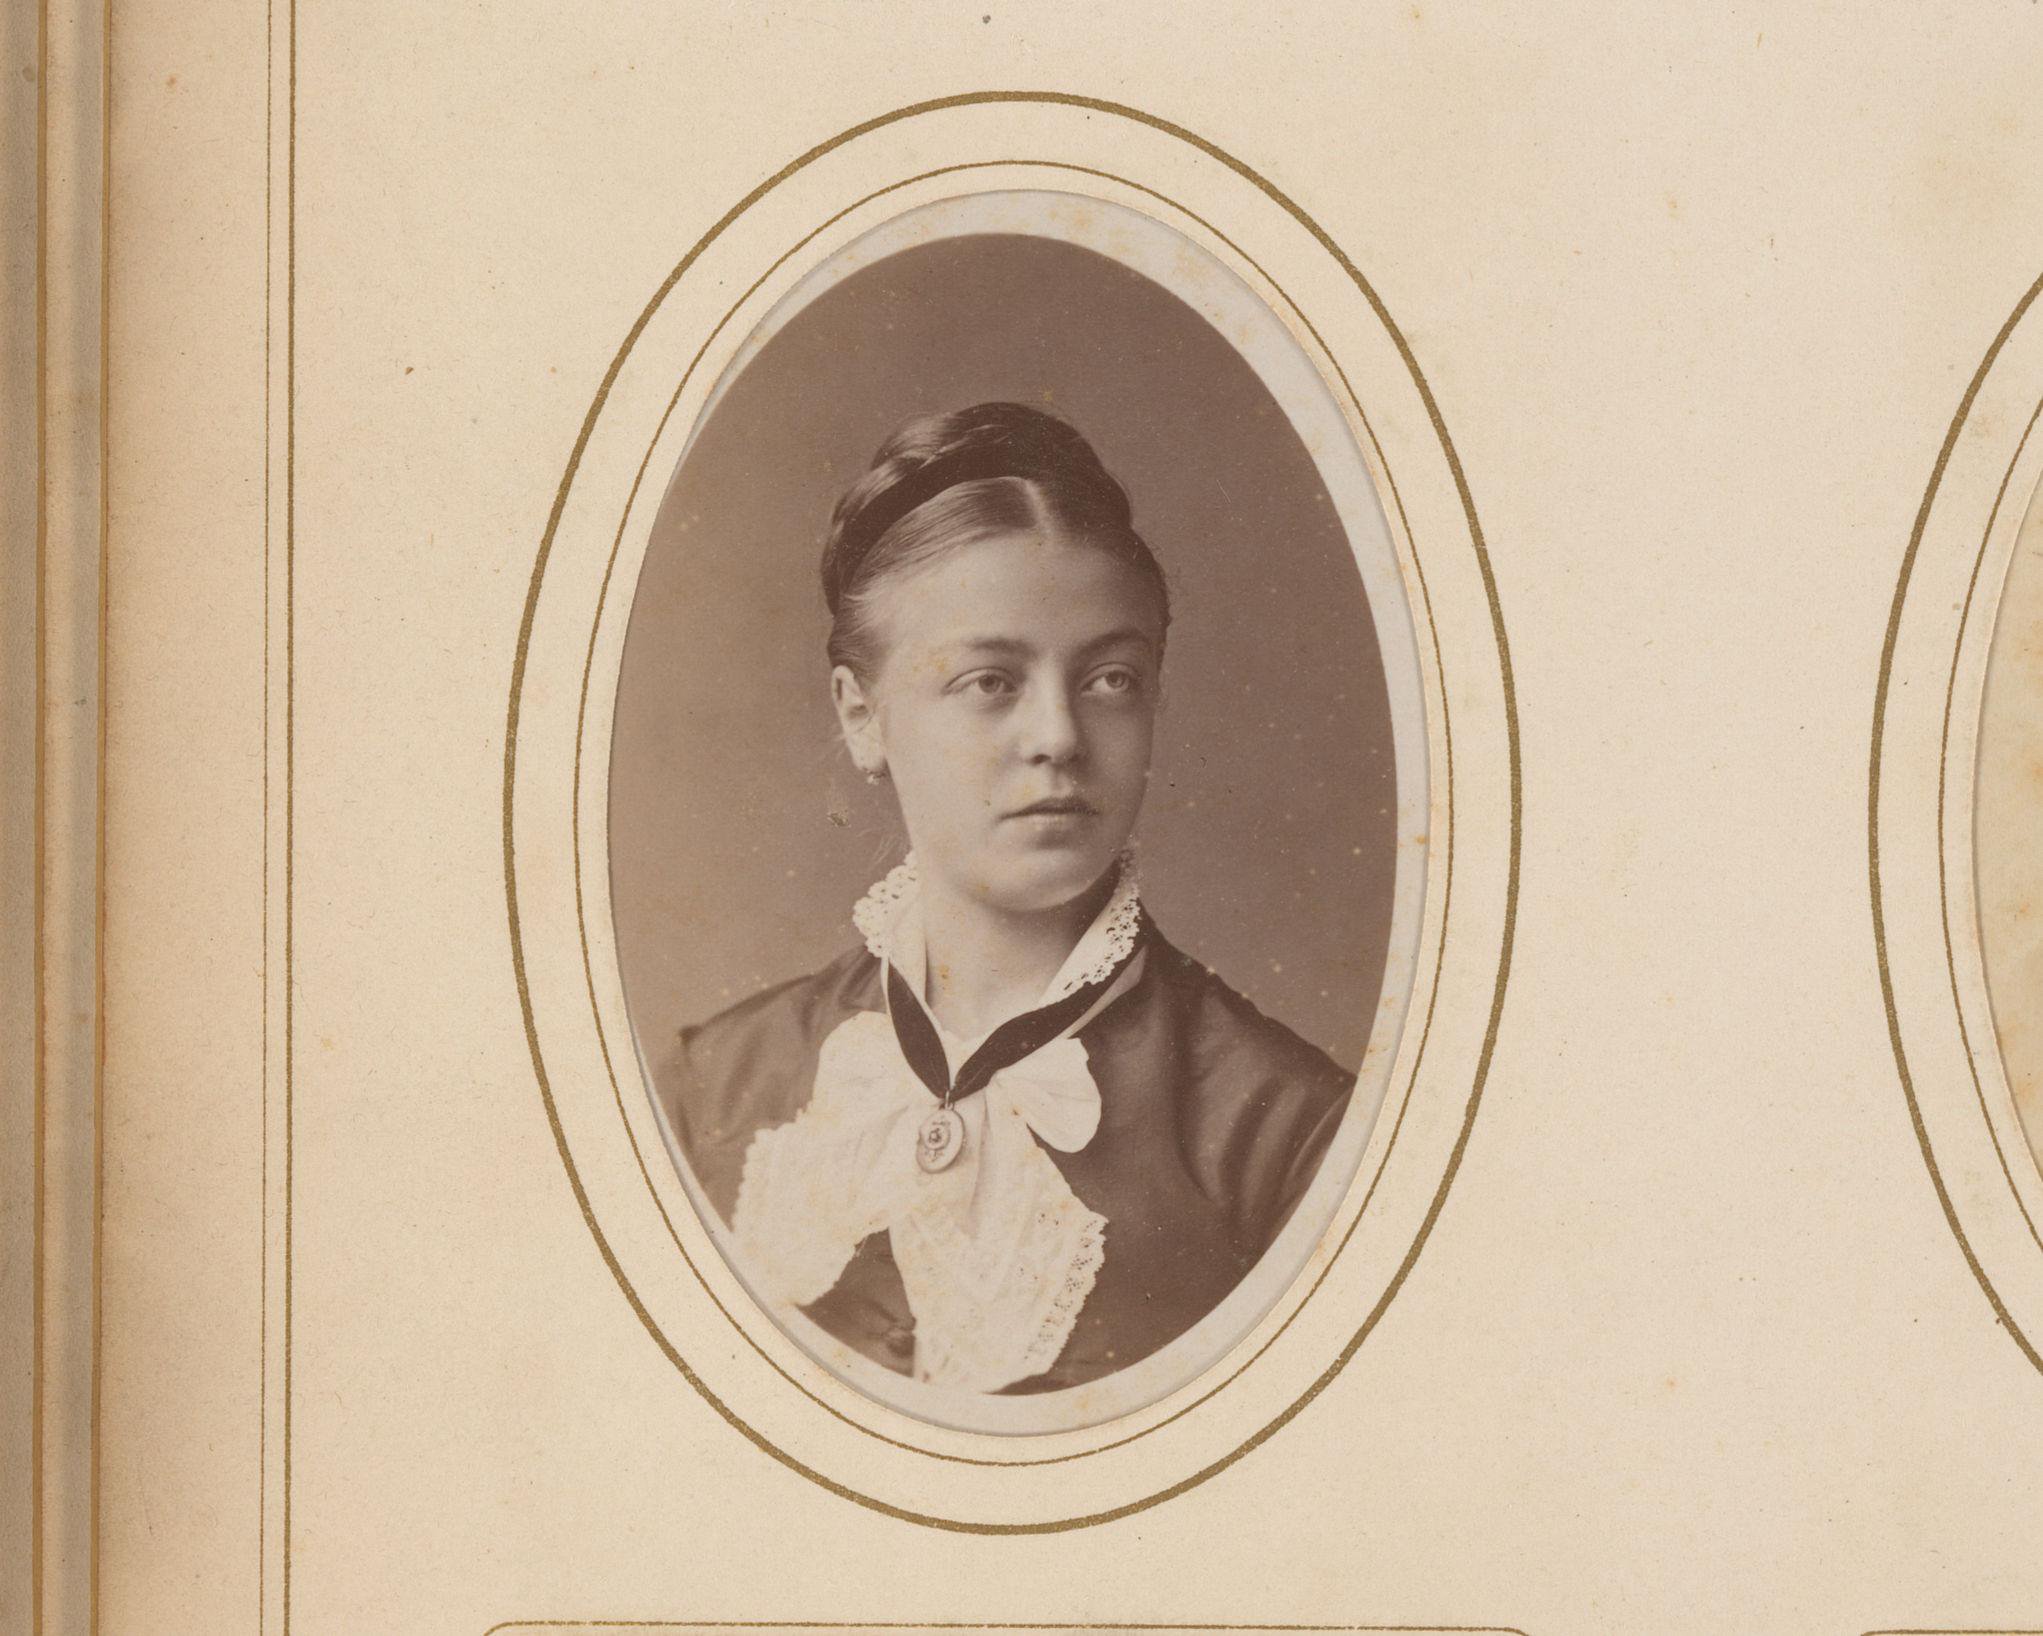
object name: photograph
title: Portret van een jonge vrouw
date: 1877-1884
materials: cardboard, photographic support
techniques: albumen print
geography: amsterdam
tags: adolescent, young woman, maiden, historical persons - bb - woman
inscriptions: inscription: ‘AMERICAN PHOTOGRAPHY./ Hisgen Bros/ PHOTO ARTISTS,/ 128, P. C. HOOFTSTRAAT/ AMSTERDAM’